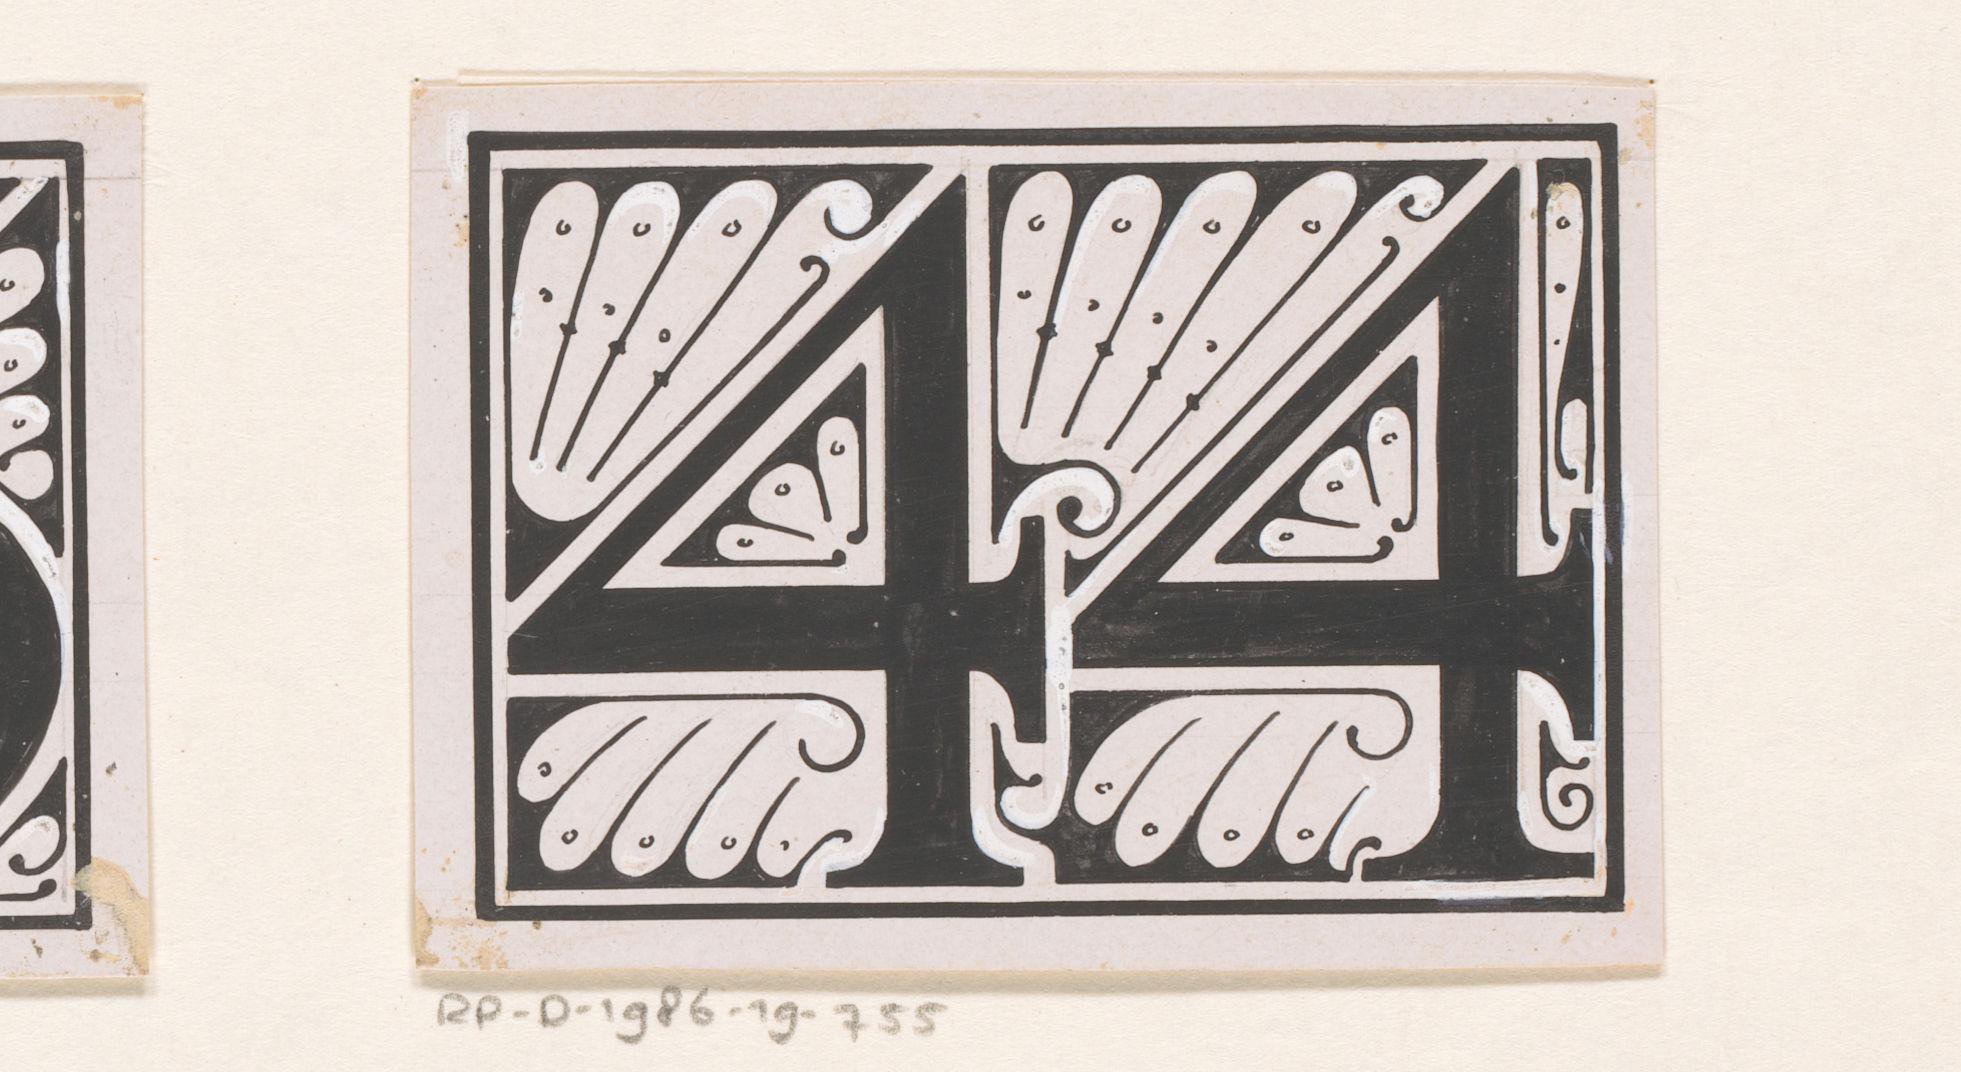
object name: design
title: Getal 44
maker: reinier willem petrus de vries (1874-1953)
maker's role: draughtsman, print maker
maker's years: 1874-1953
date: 1904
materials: paint, ink, paper, pencil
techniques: brush, pen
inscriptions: collector's mark: ‘R:MVS.’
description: Het getal is gebruikt voor: Veth, Jan. Jozef Israëls en zijn kunst. Arnhem en Nijmegen: Gebroeders E&M Cohen, 1904.